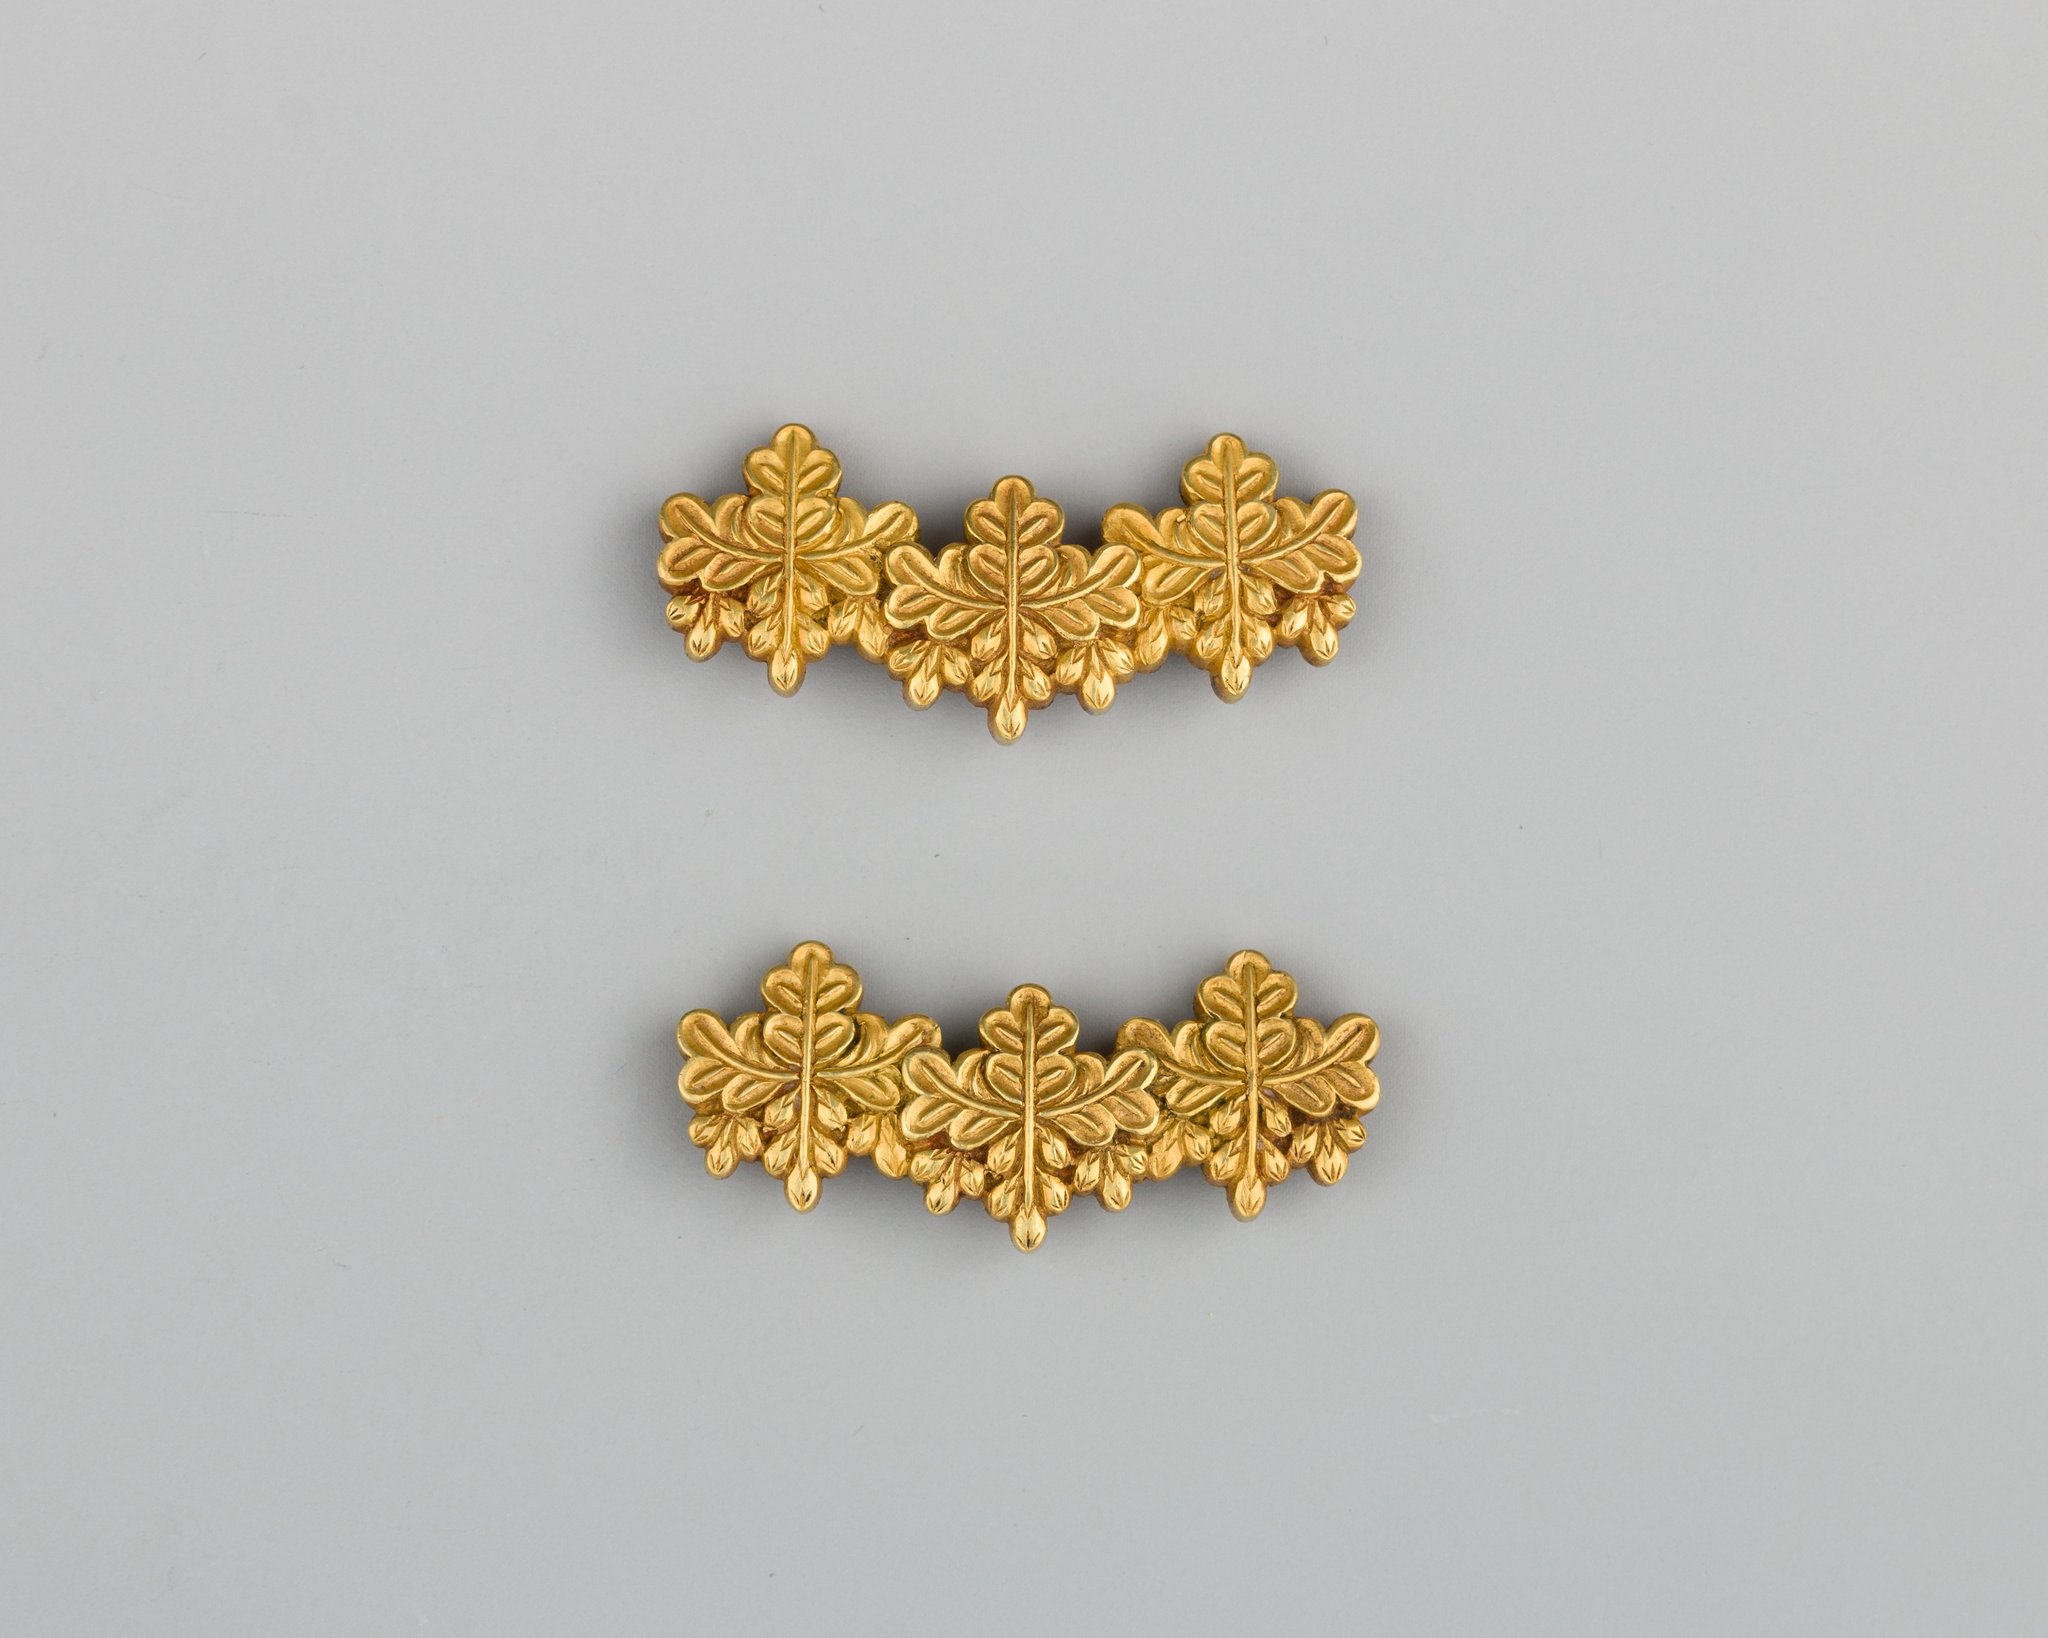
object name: pair of sword grip ornament menuki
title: Pair of Sword-Grip Ornaments (Menuki)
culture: japanese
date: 1701-1800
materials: gold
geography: japan